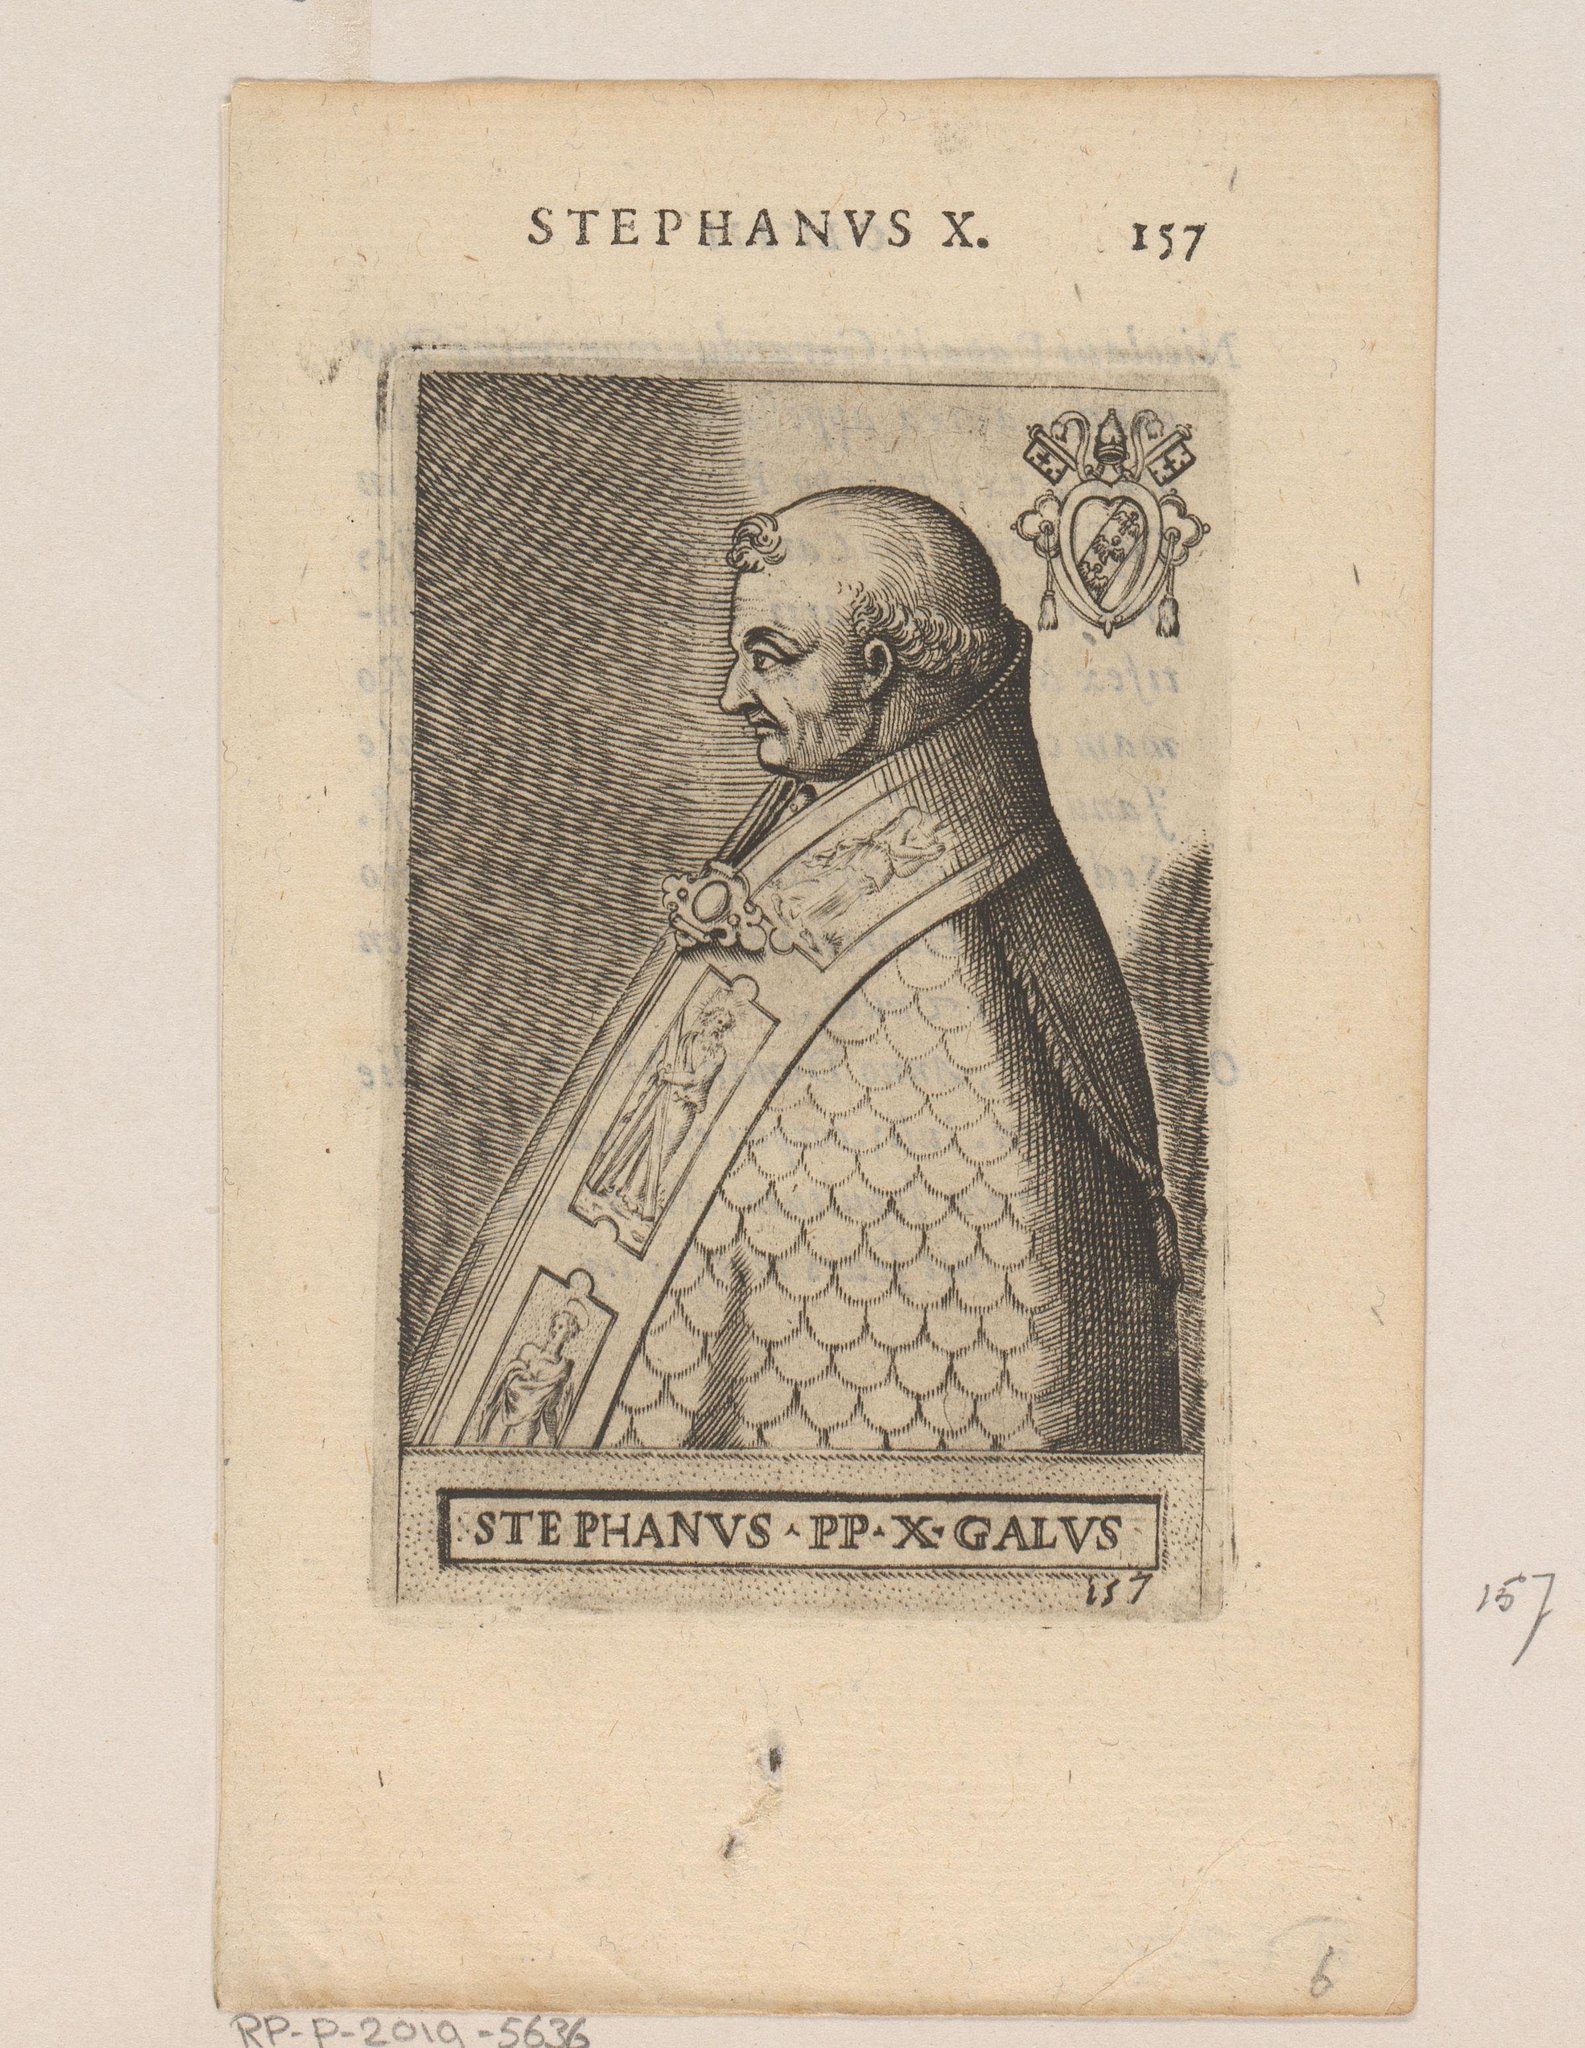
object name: print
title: Portret van paus Stefanus IX (X)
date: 1595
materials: paper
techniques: engraving, letterpress printing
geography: rome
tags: historical persons, pope, armorial bearing, heraldry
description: Prent uit: Cavalieri, Giovanni Battista de'. Effigies pontificum romanorum cum eorum vitis (...). Rome: Bartolomeo Bonfadino, 1595. Prent voor het eerst verschenen in: Cavalieri, Giovanni Battista de'. Pontificum romanorum effigies (...). Rome: Domenico Basa en Francesco Zanetti, 1580. Prent ook gebruikt in latere publicaties.